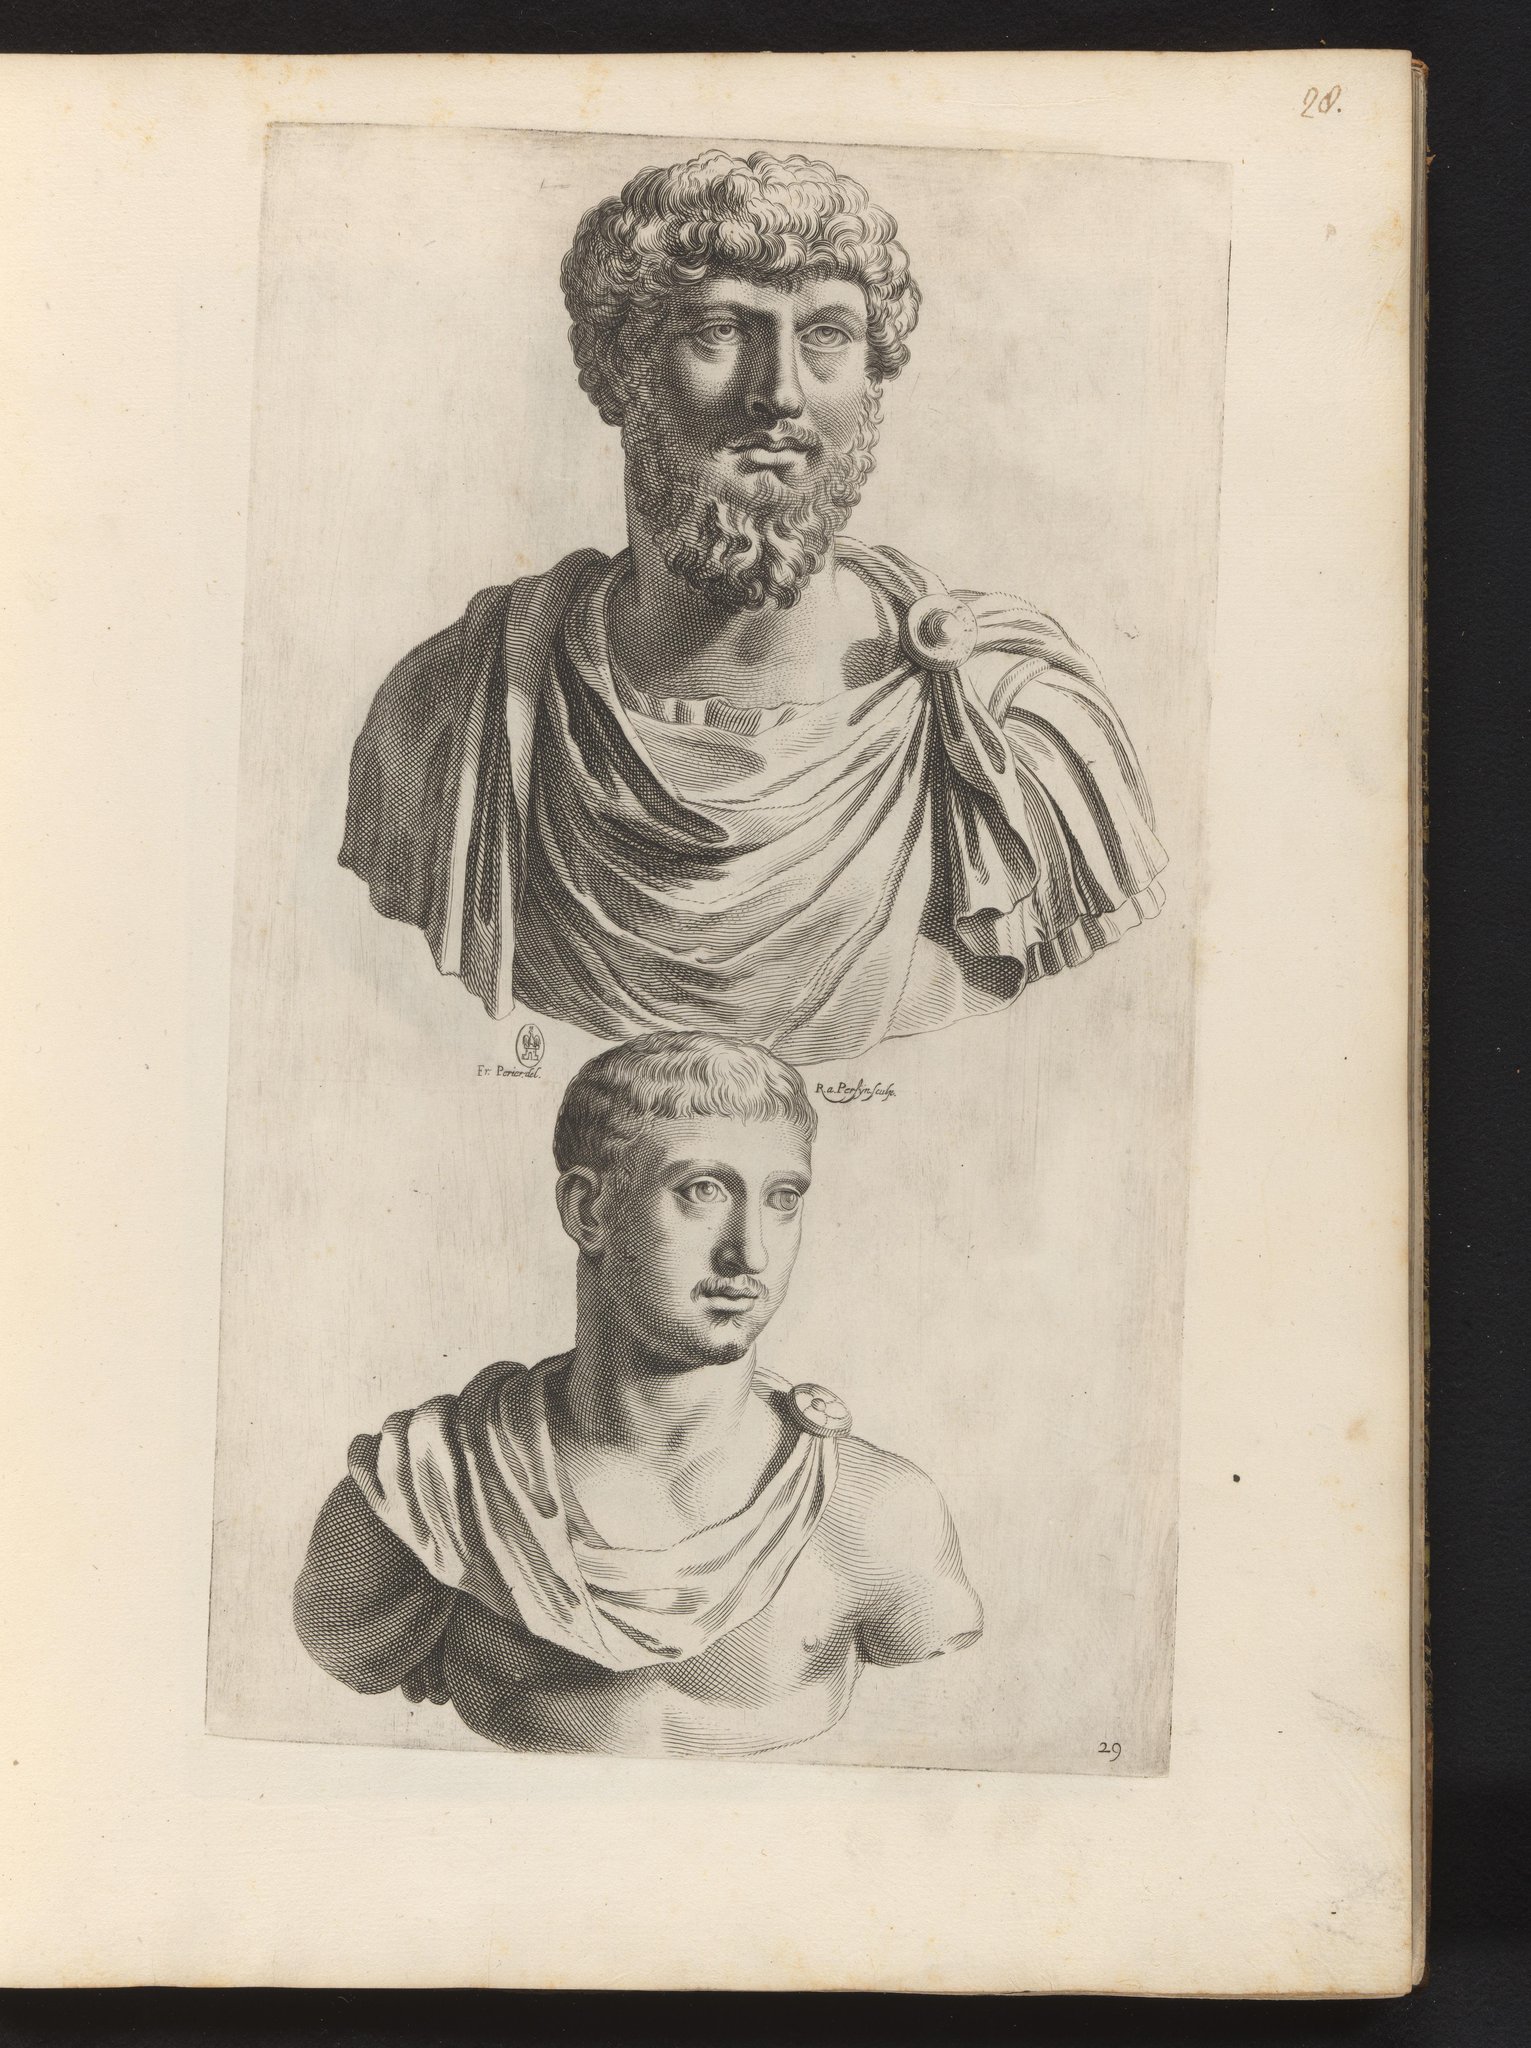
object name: album leaf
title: Galleria Giustiniana del Marchese Vincenzo Giustiniani II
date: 1636-1647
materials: paper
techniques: engraving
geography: rome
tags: male persons from classical history (+ head, bust, etc.), piece of sculpture, reproduction of a piece of sculpture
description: Twee Romeinse portretbustes van keizer Lucius Verus en keizer Alessandro Severo. In het midden het wapenschild van Vincenzo Giustiniani. Prent maakt deel uit van een album met een serie prenten naar de sculpturen in de verzameling in de Galleria Giustiniani te Rome.